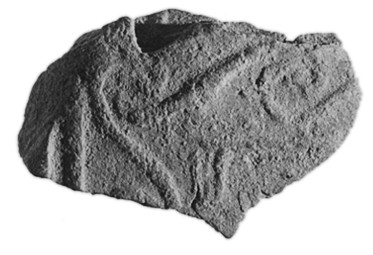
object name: sealing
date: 2030-1640 BCE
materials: clay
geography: egypt